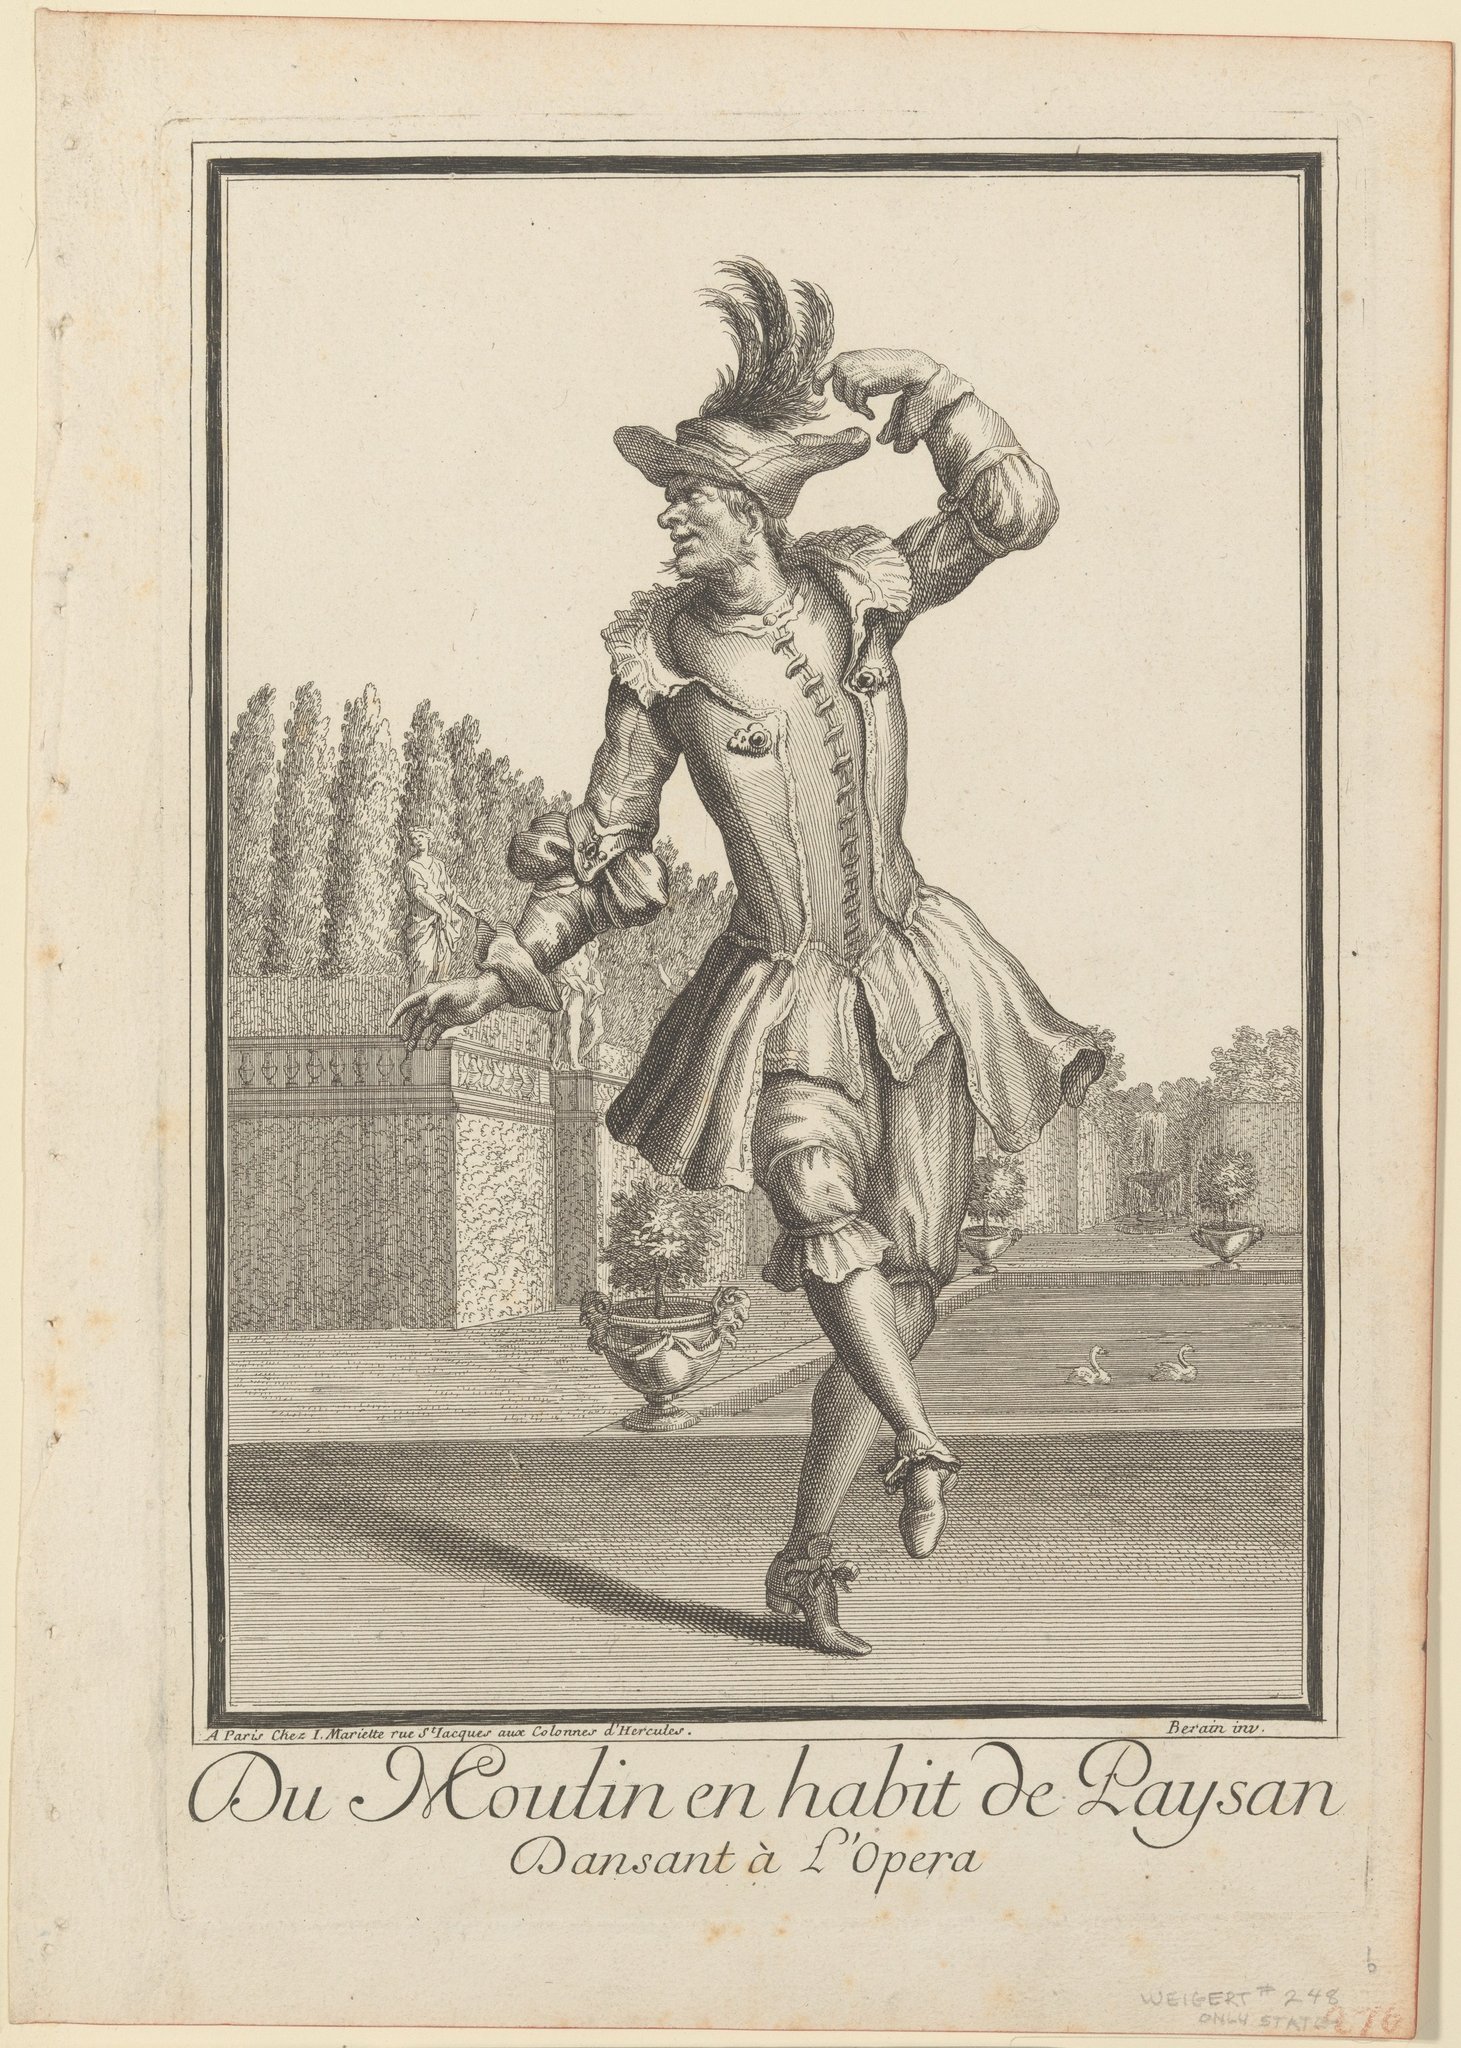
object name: print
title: Du Moulin in Peasant Garb Dancing at the Opera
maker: jean berain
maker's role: artist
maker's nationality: french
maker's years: 1640-1711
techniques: engraving, etching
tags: men,dancing